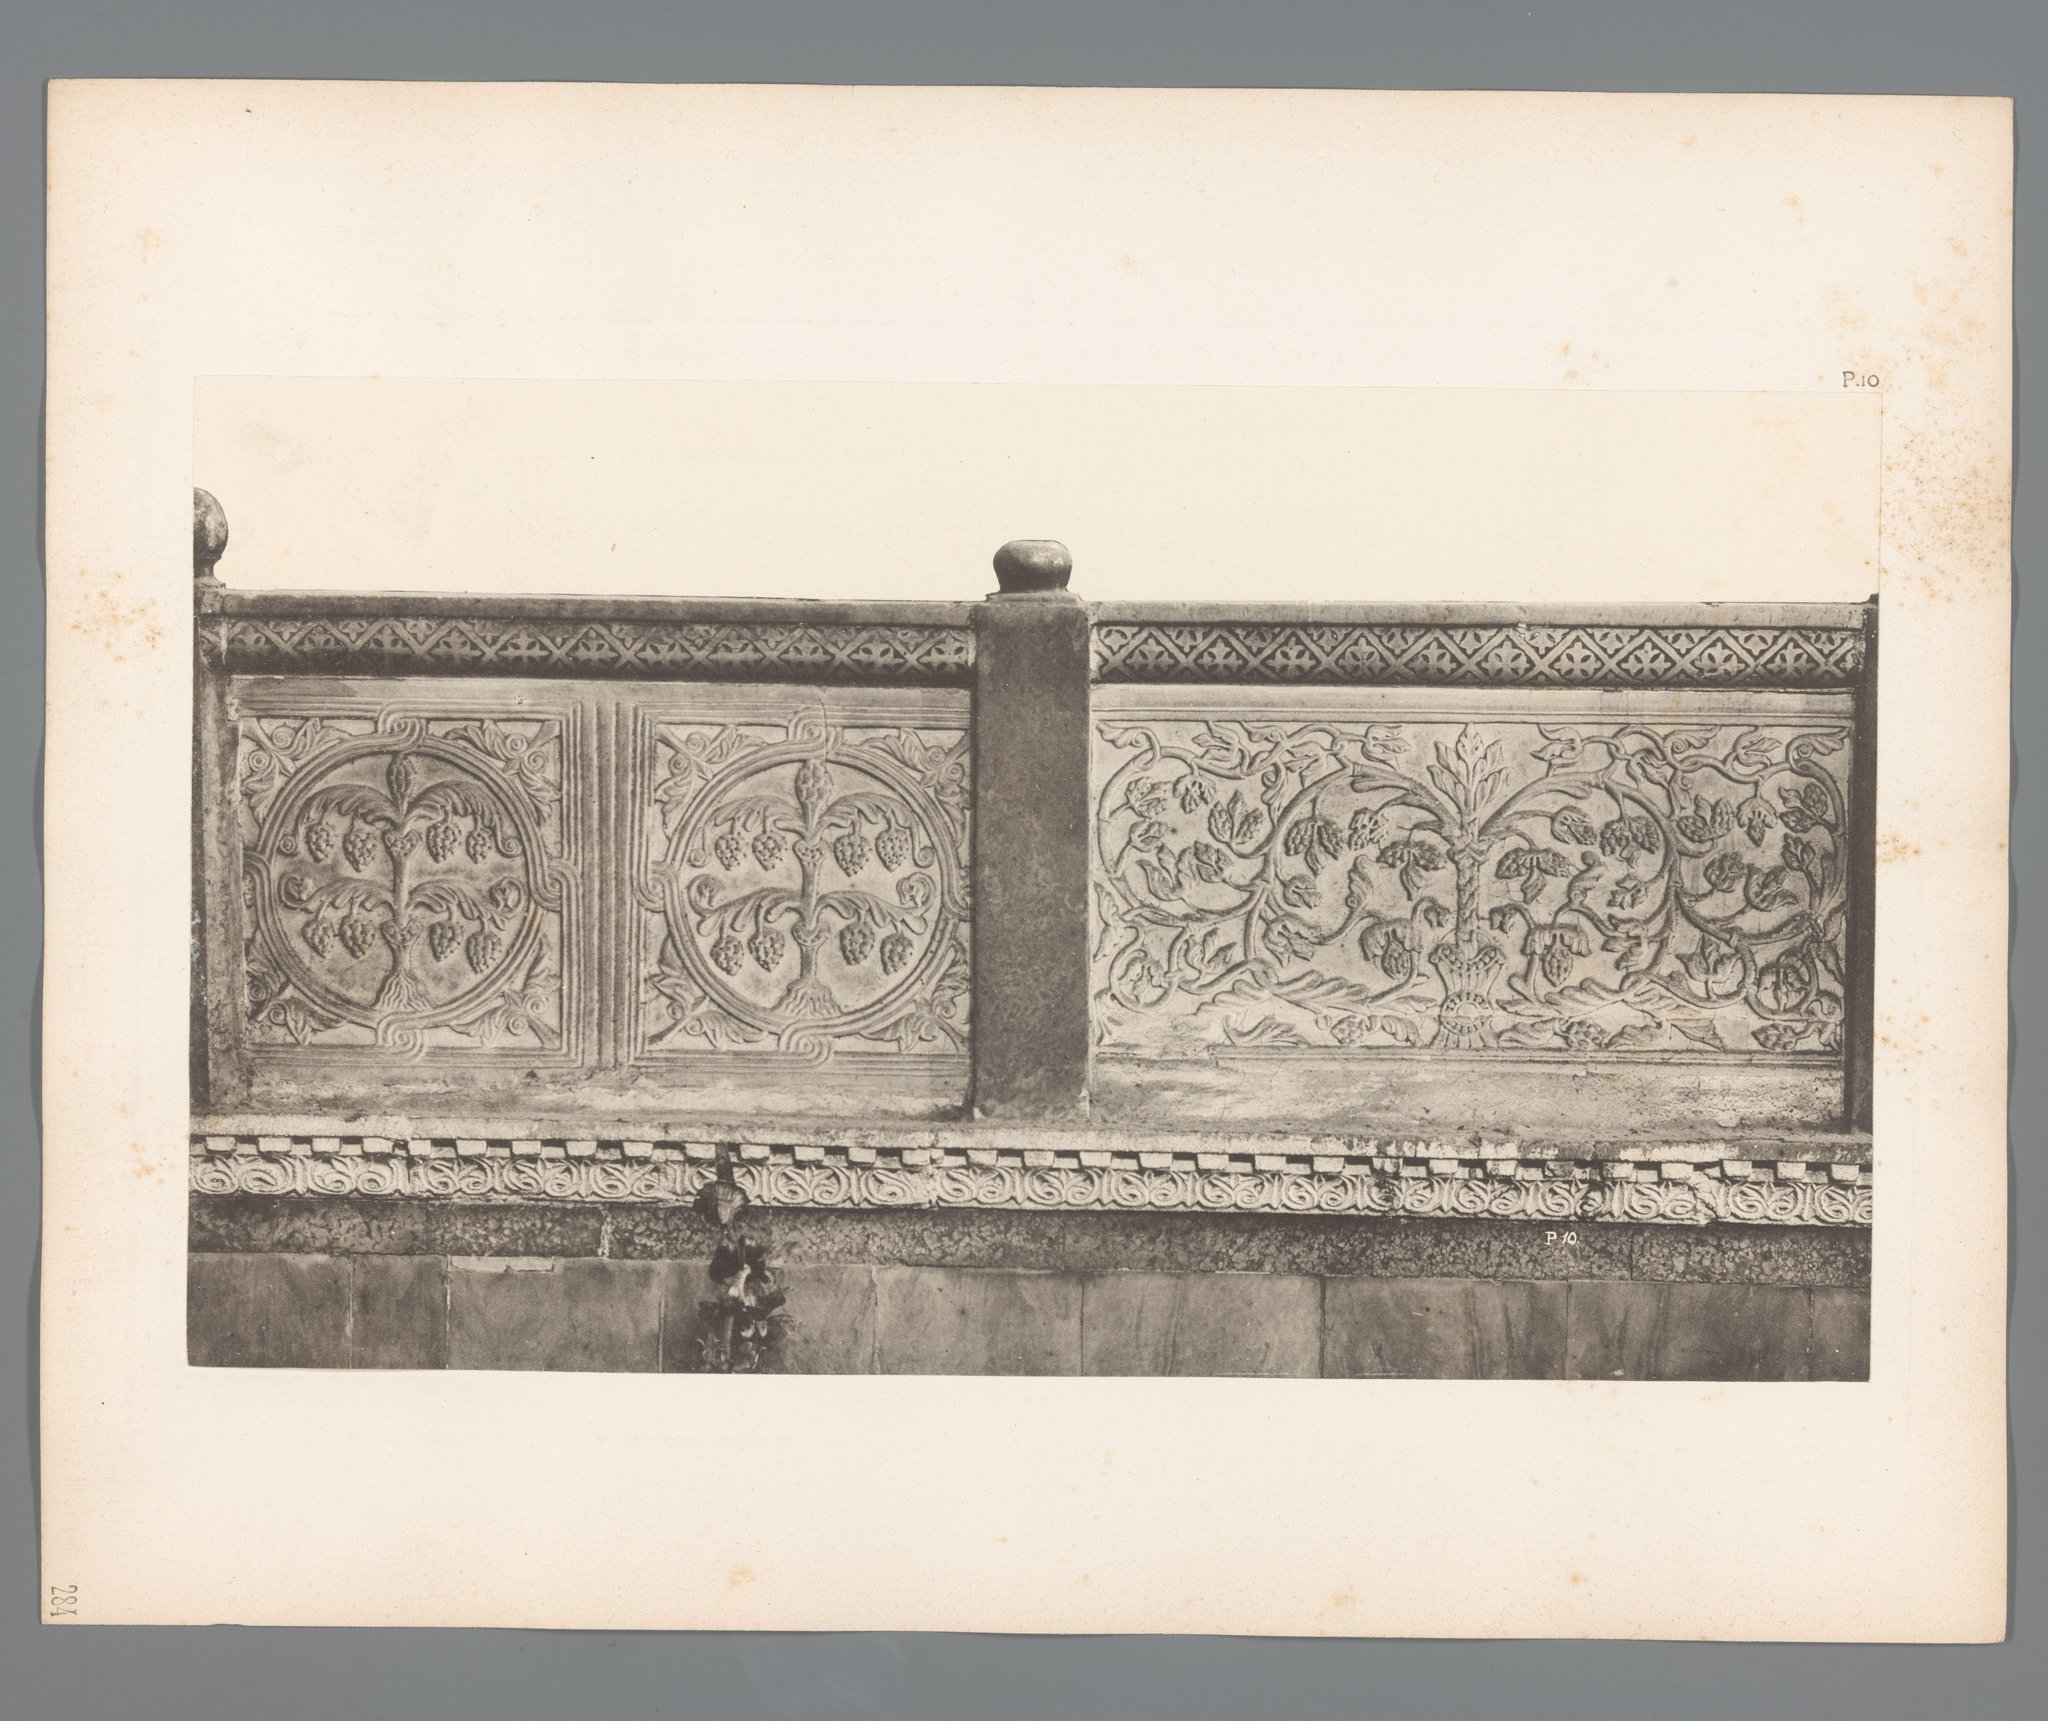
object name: photomechanical print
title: Balustrade met reliëf in de San Marco in Venetië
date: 1880-1885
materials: paper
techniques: photograph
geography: st. mark's basilica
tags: balustrade, piece of sculpture, reproduction of a piece of sculpture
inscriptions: number: ‘P 10.’, number: ‘284’, number: ‘P.10’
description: Deze prent maakt deel uit van een omslag met 58 prenten op 50 bladen.